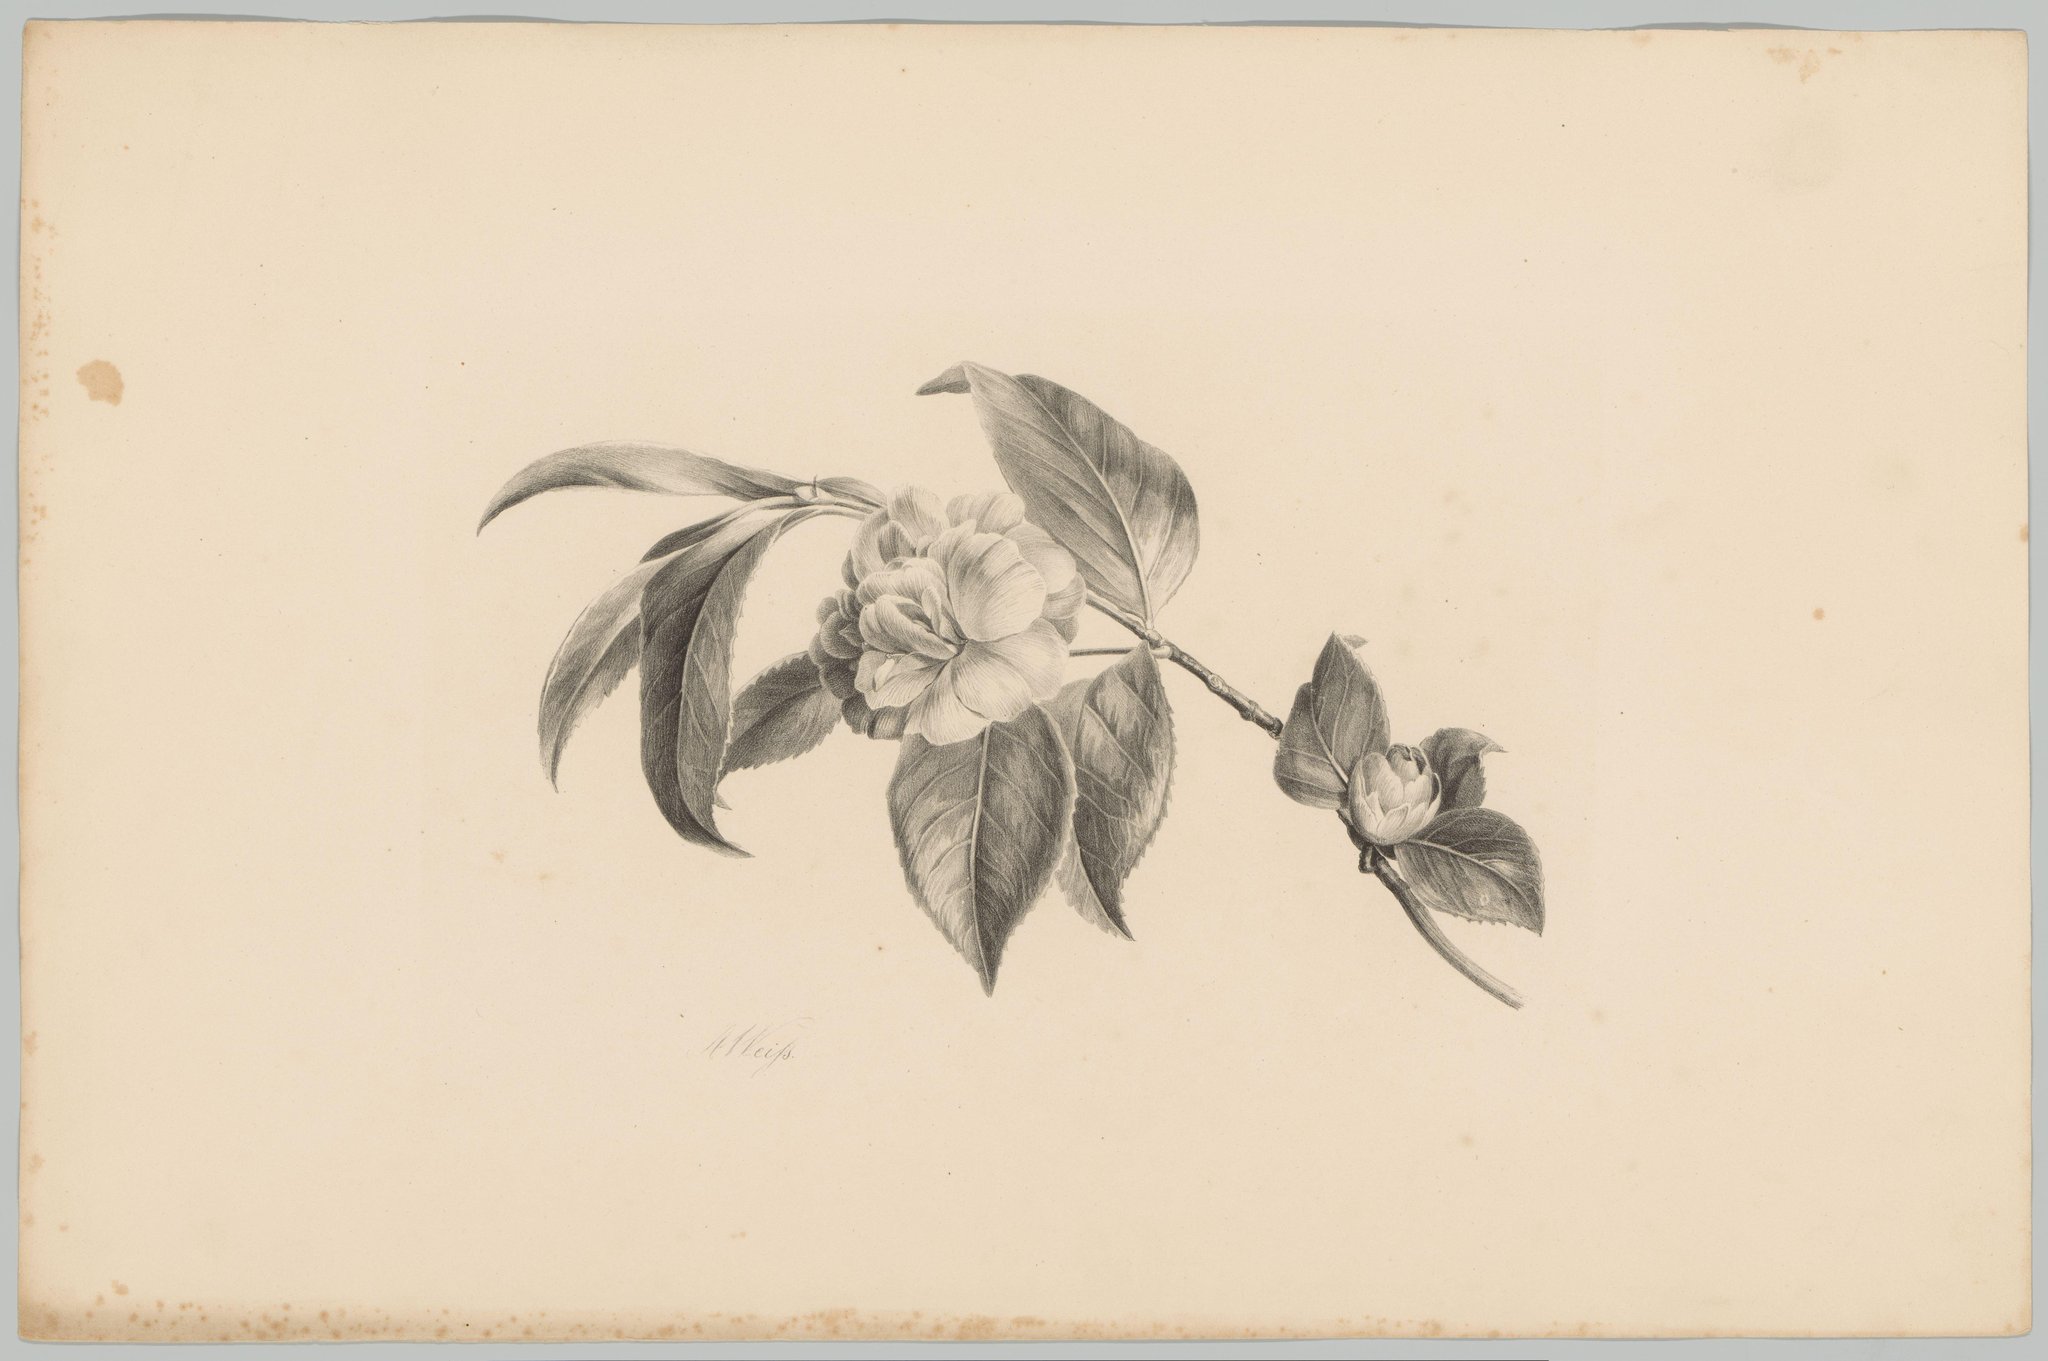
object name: print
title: Bloem en Fruit Studien (...) 3de aflevering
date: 1820-1833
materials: paper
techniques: lithograph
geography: amsterdam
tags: flowers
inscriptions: collector's mark: Lugt 2228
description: Onderdeel van een omslag met in totaal zevenenzeventig lithografieën van bloemen en fruit.